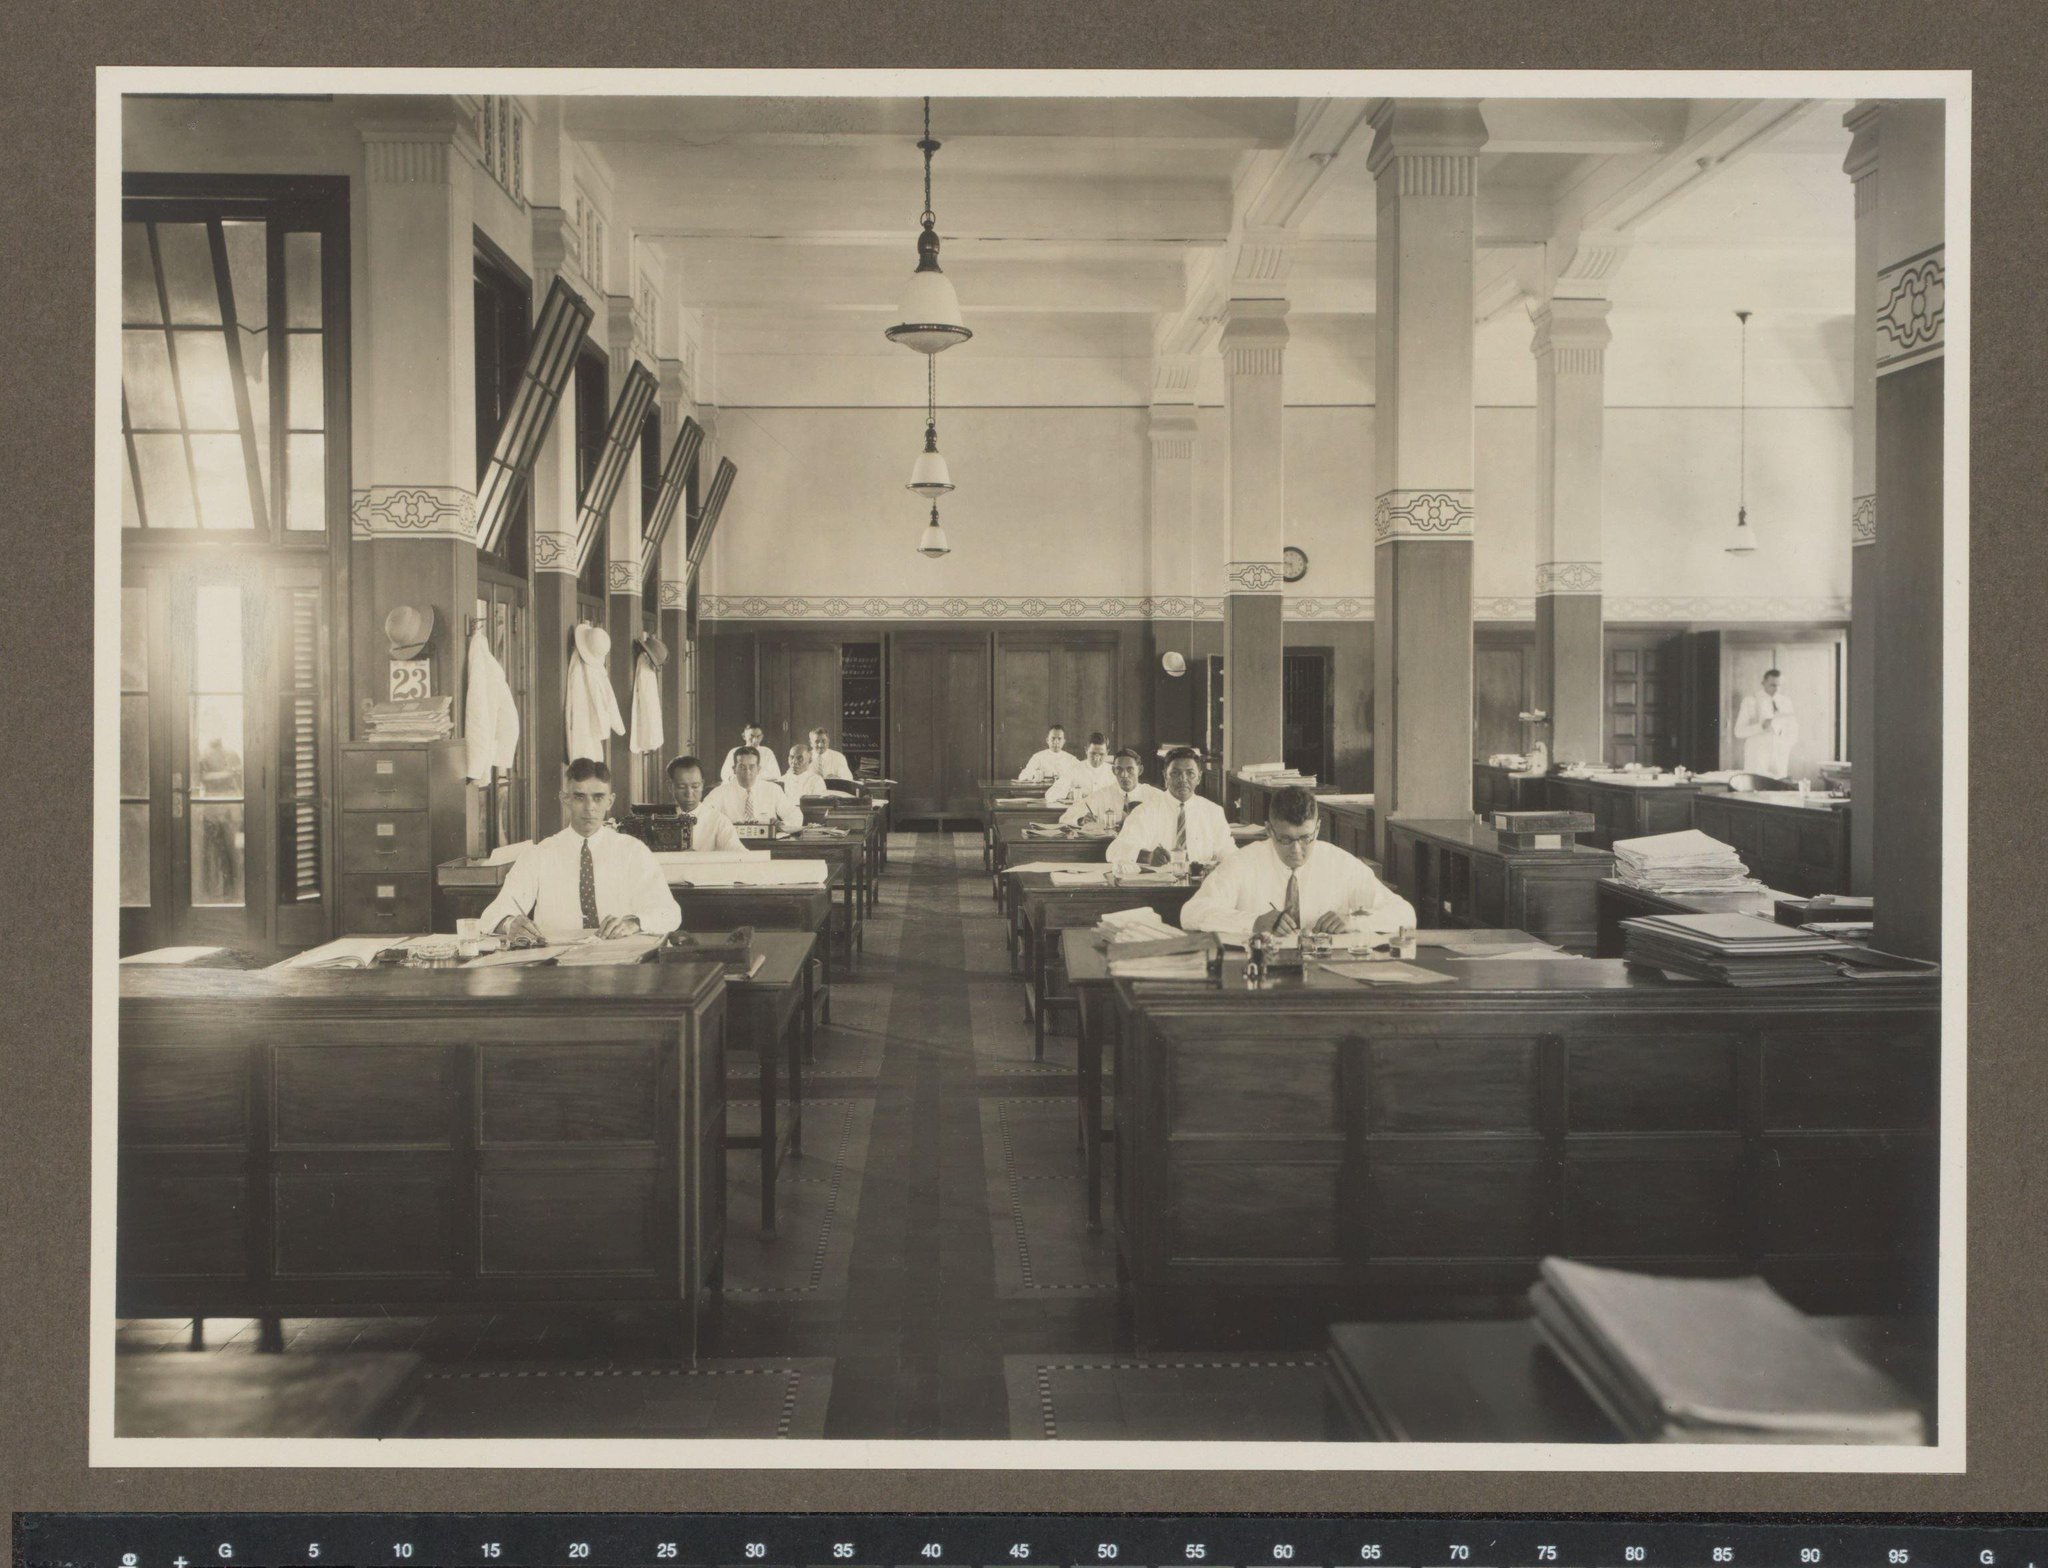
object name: photograph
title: Cultuurafdeeling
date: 1904-1931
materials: photographic support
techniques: gelatin silver print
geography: surabaya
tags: colonial system, trade-company, administration ~ trade and finance, surabaya, java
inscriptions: inscription: ‘Cultuurafdeeling’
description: Het kantoor van de chefs van de cultuurafdeling. Foto genomen op 23 april 1931. Foto in het het fotoalbum aangeboden aan A. van der Eyk namens de chefs en het personeel van de Handelsvereniging Amsterdam (HVA) te Soerabaja bij zijn vertrek van Java in april 1931.